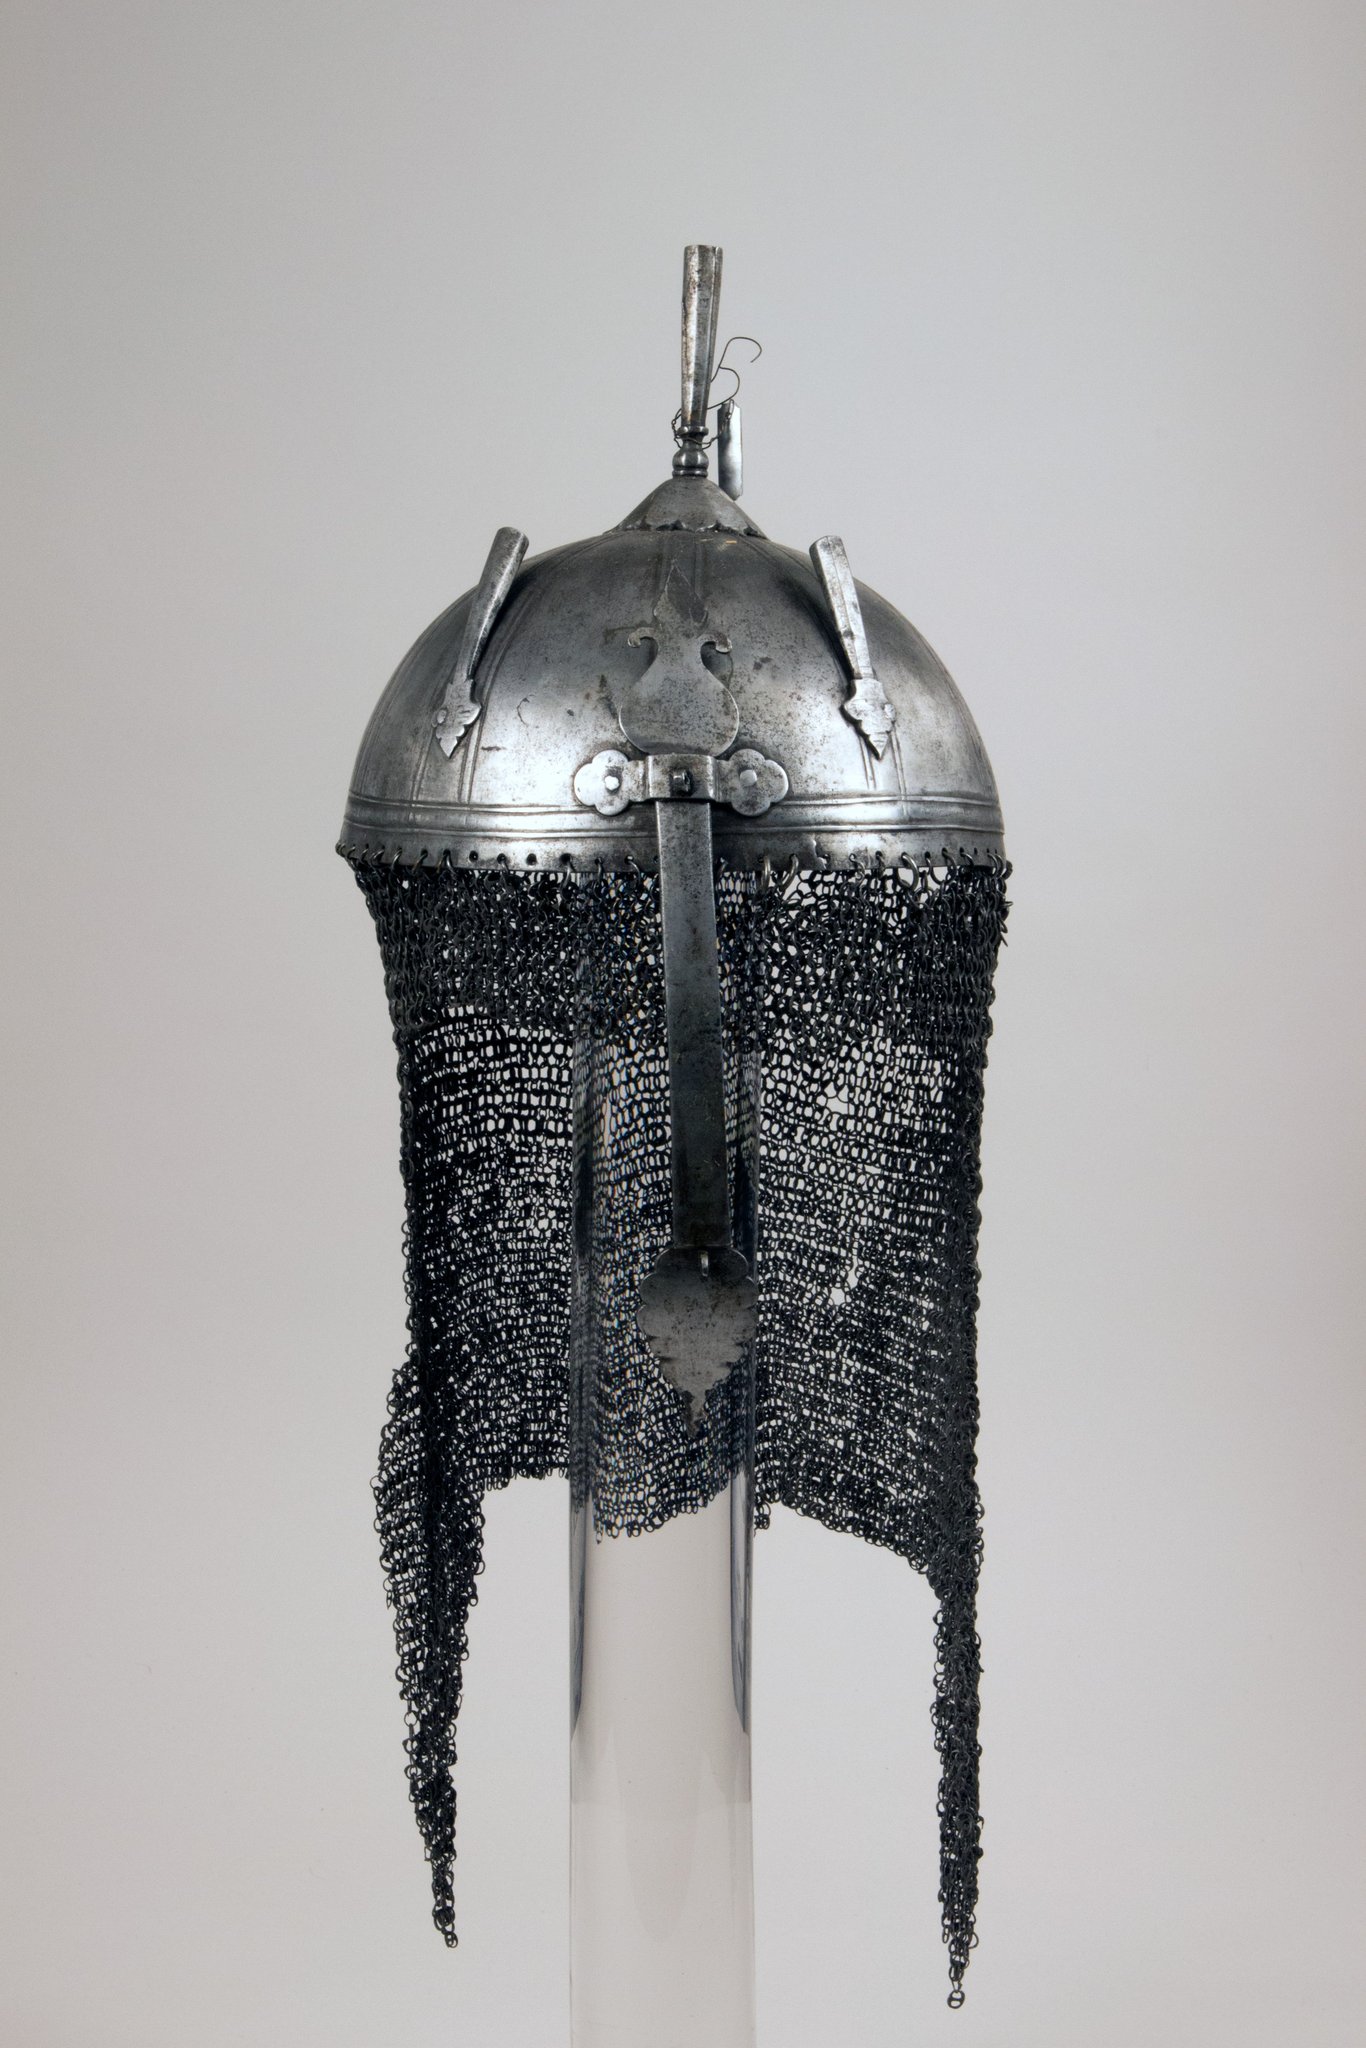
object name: helmet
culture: indian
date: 1701-1900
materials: steel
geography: india